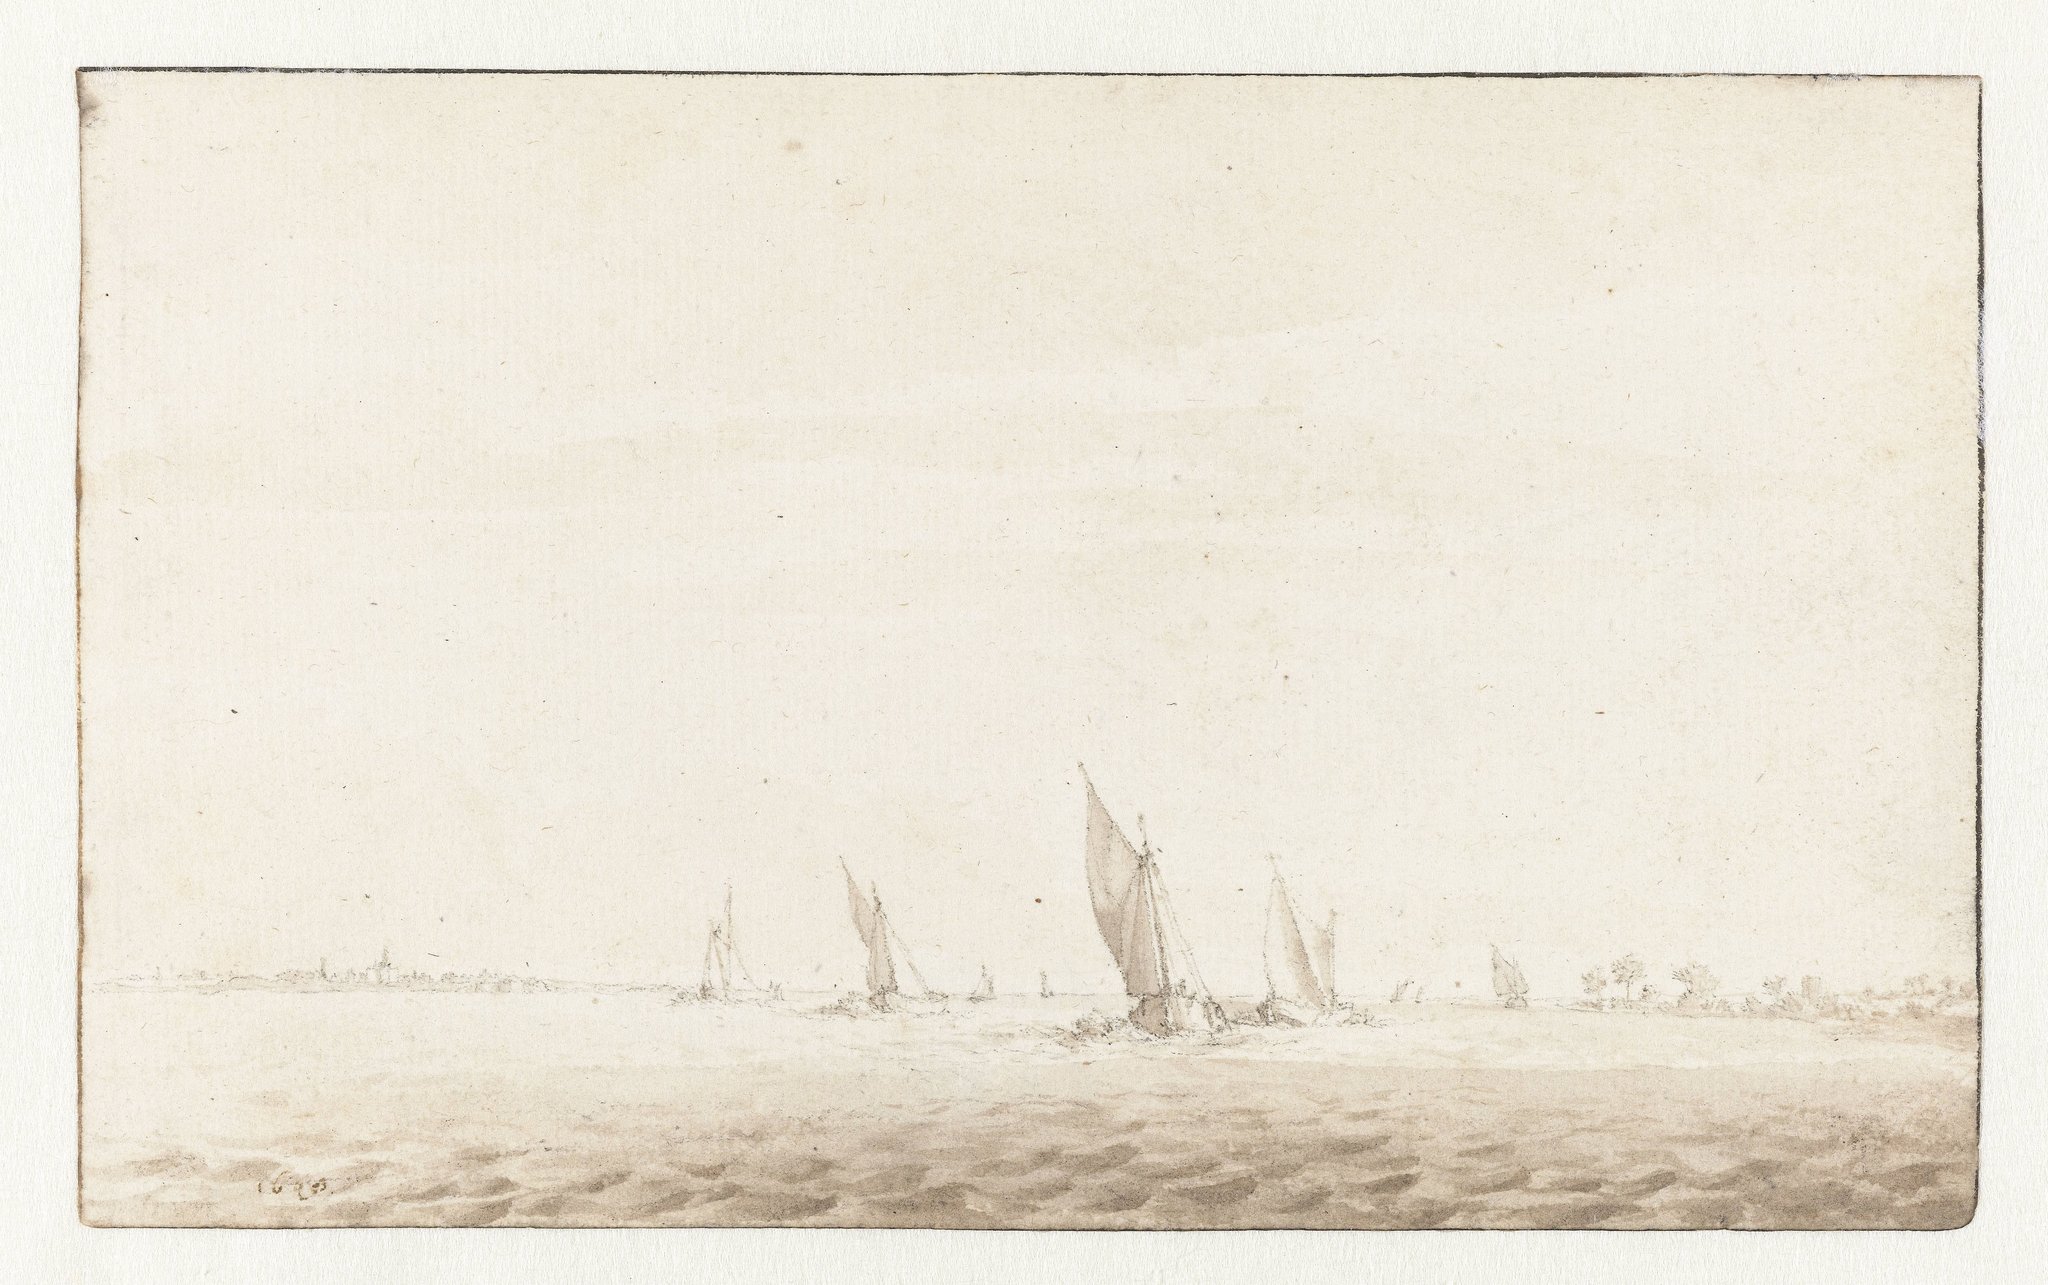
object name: drawing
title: Oosterschelde voor Bergen op Zoom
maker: jan de bisschop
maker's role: draughtsman, print maker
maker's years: 1628-1671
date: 1648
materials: chalk, paper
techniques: brush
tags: sailing-ship, sailing-boat, sea (seascape), bergen op zoom